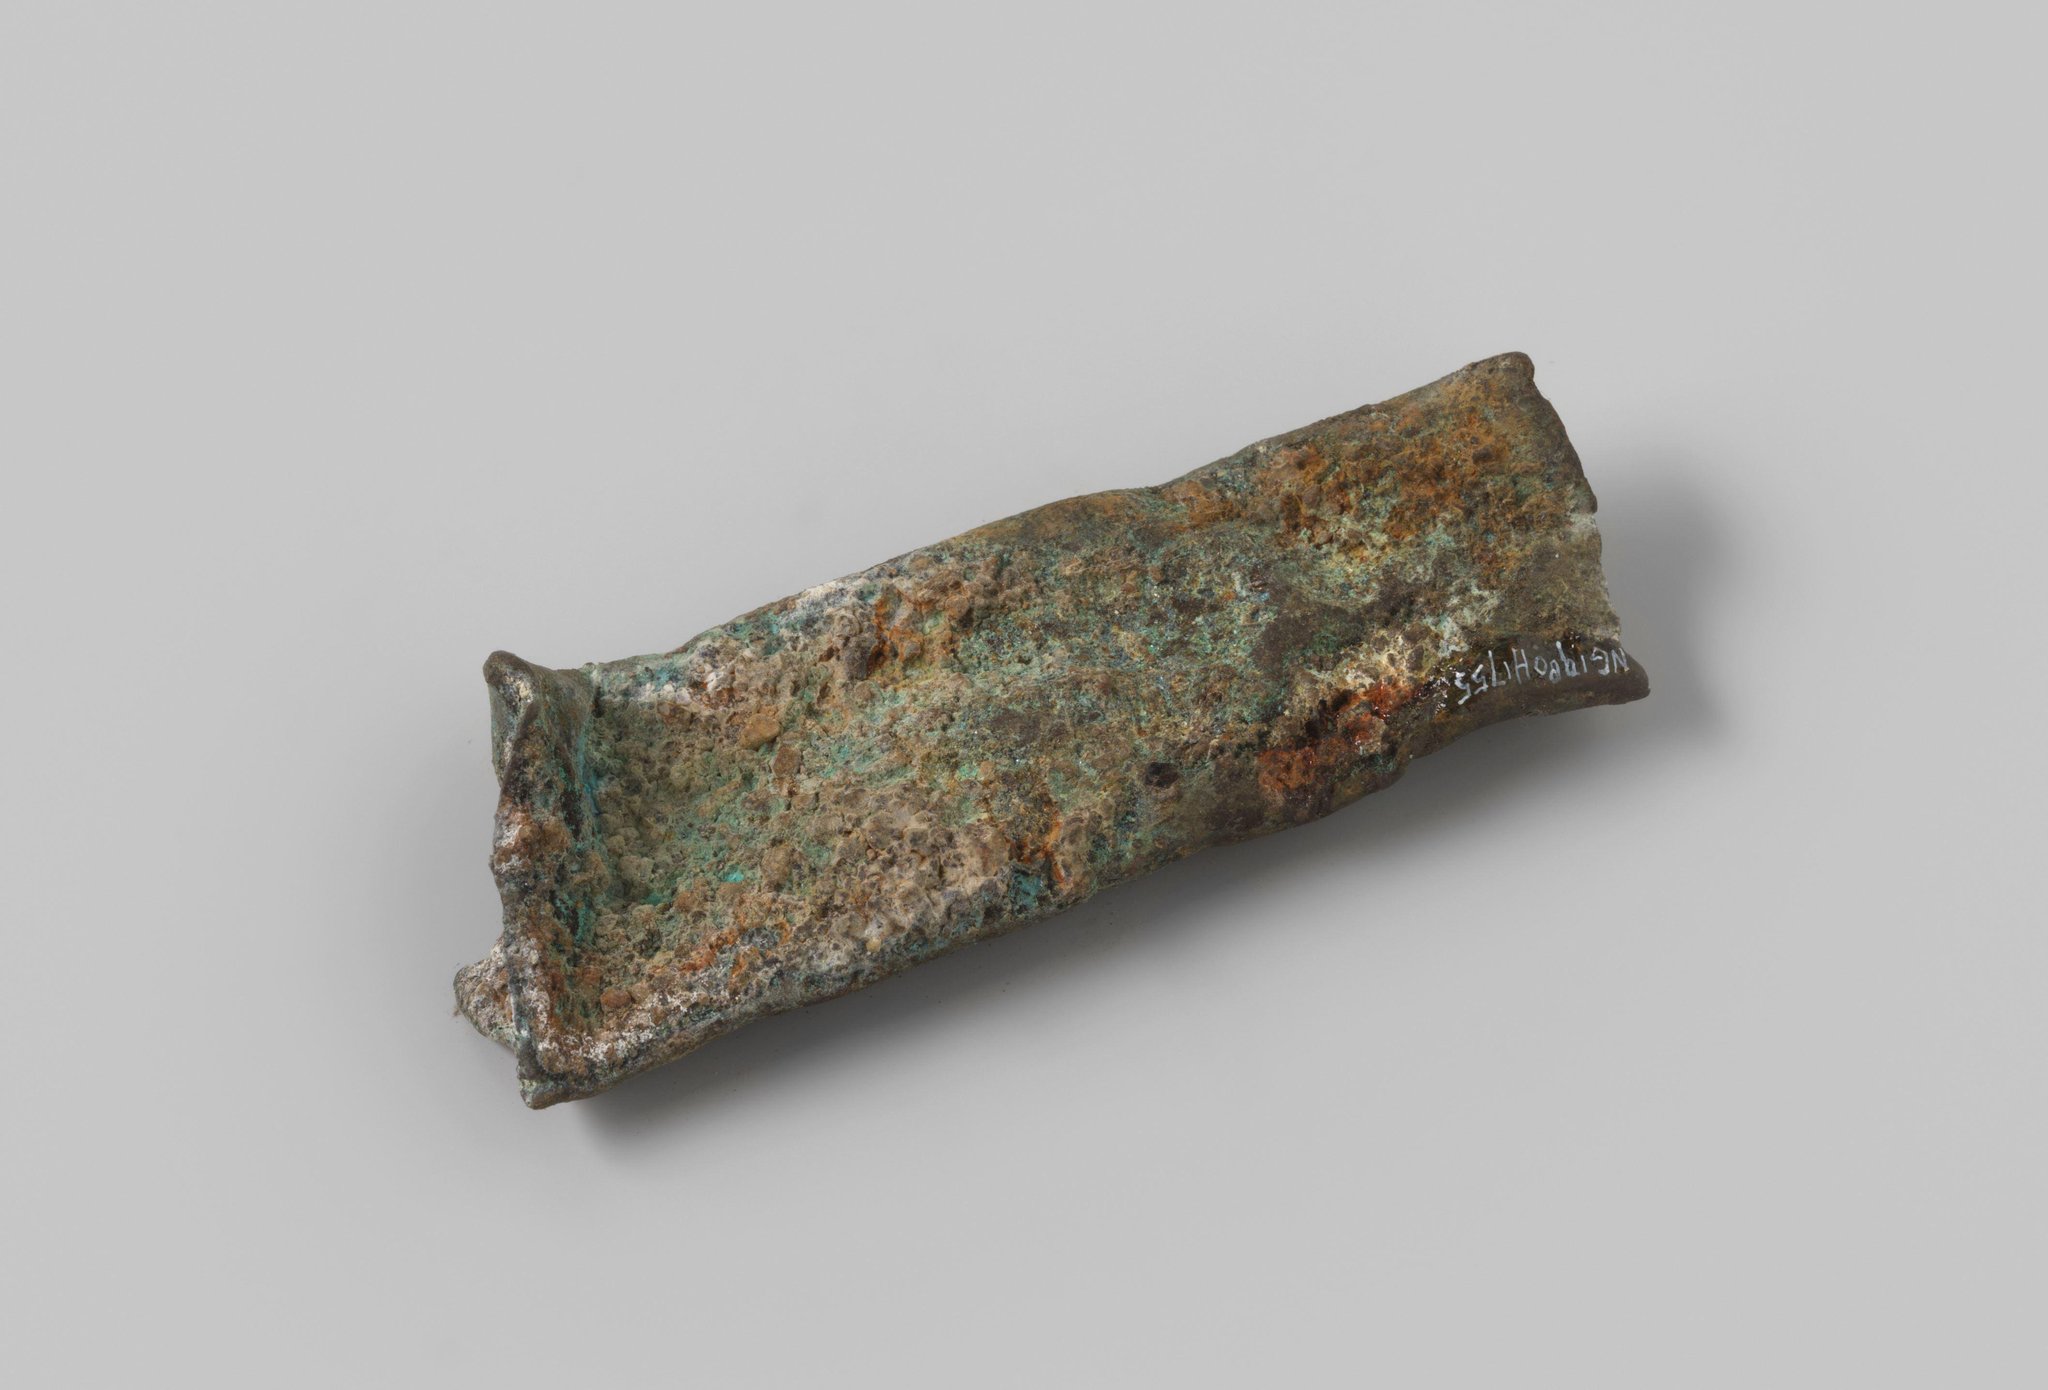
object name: cartridge shell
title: Patroonhuls uit het wrak van de Oost-Indiëvaarder Hollandia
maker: Anonymous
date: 1700-1743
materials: copper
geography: netherlands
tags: verenigde oostindische compagnie, hollandia (schip), annet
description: Cartridge case, tube; squashed, corroded, id. NG 1979-205H549.